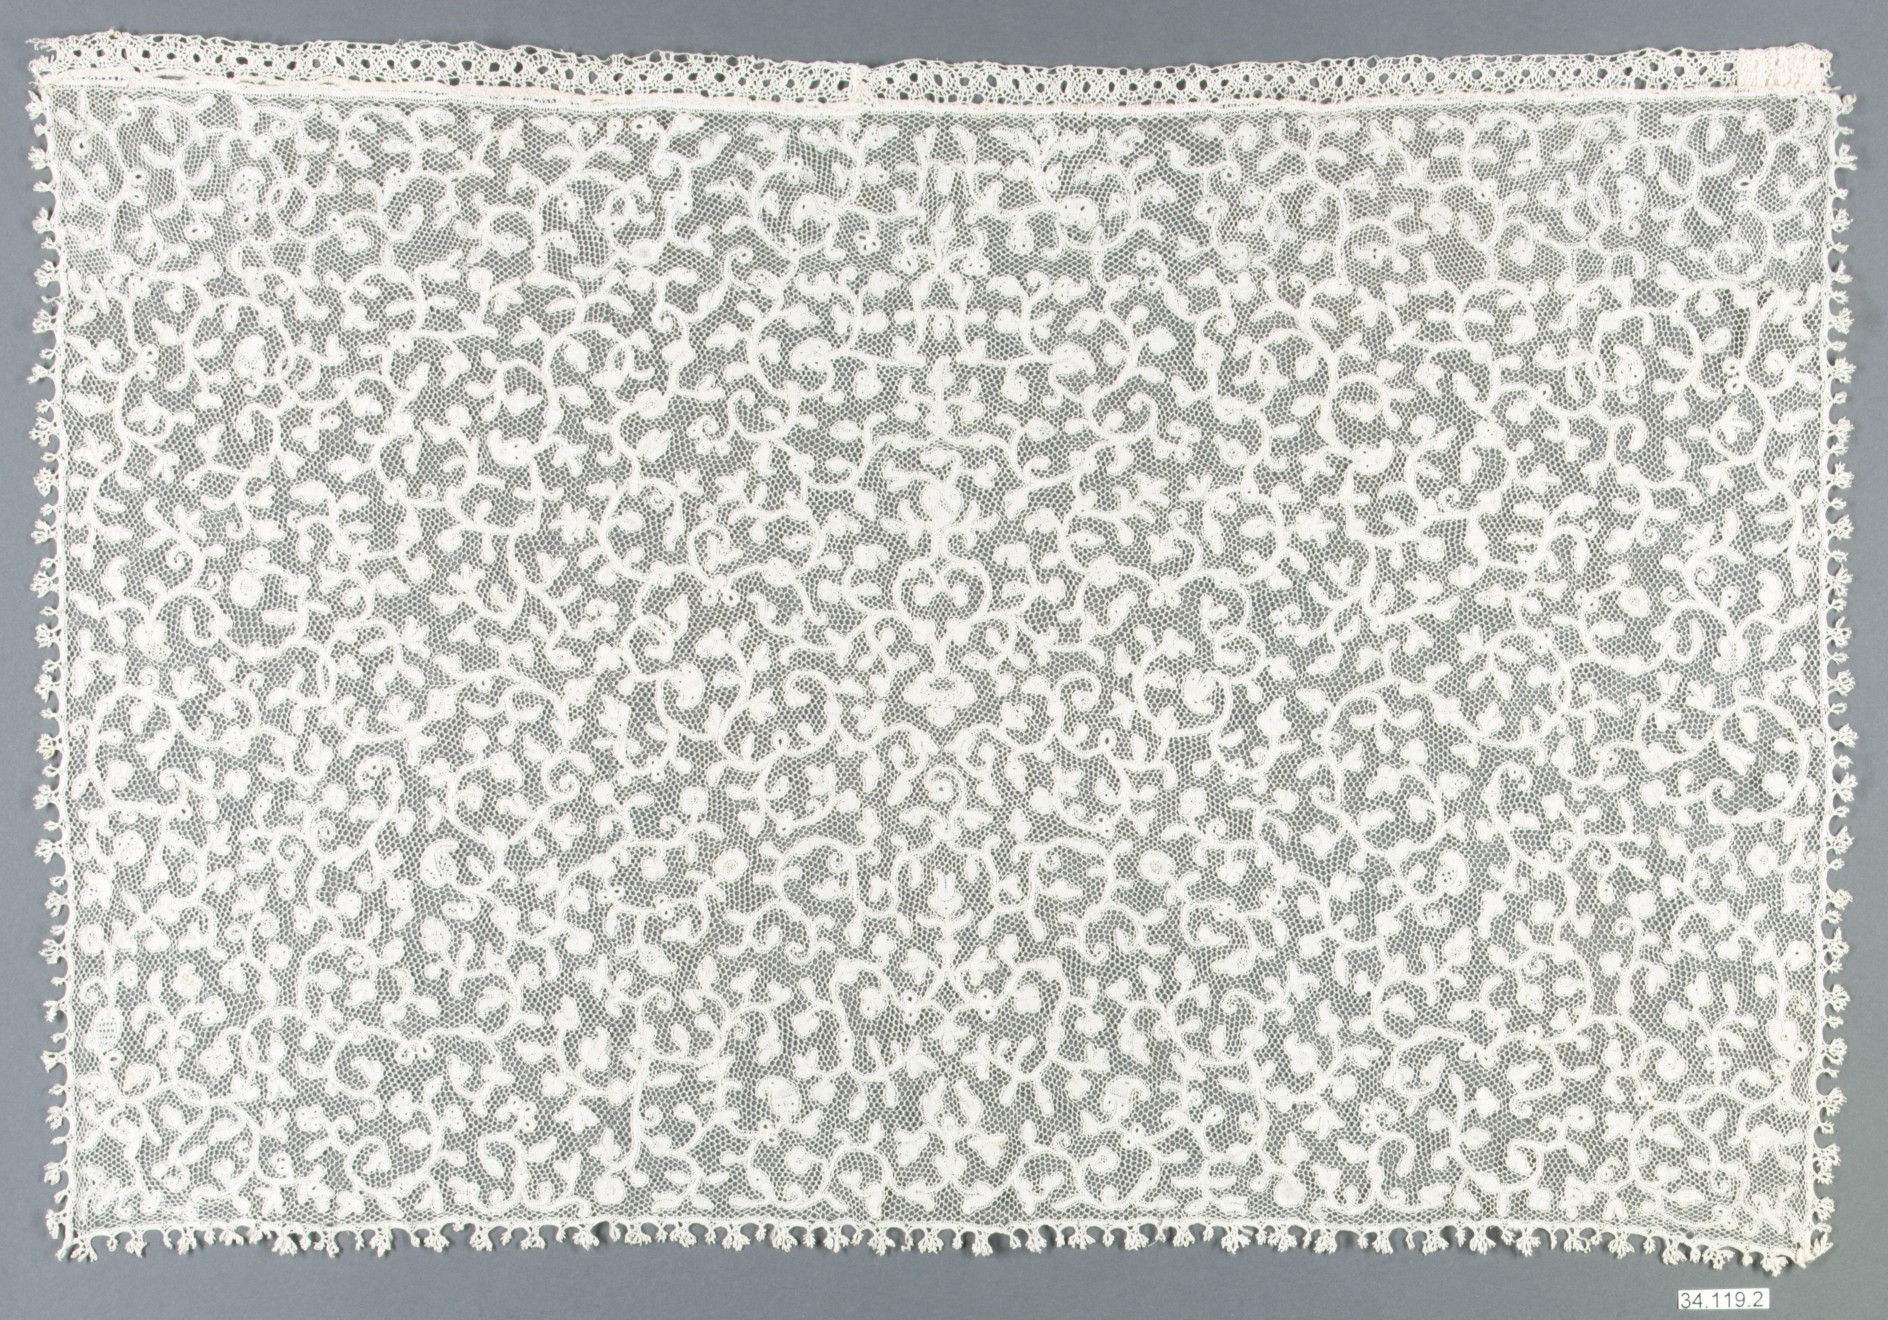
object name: cravat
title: Cravat (one of a pair)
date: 1701-1733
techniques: lace